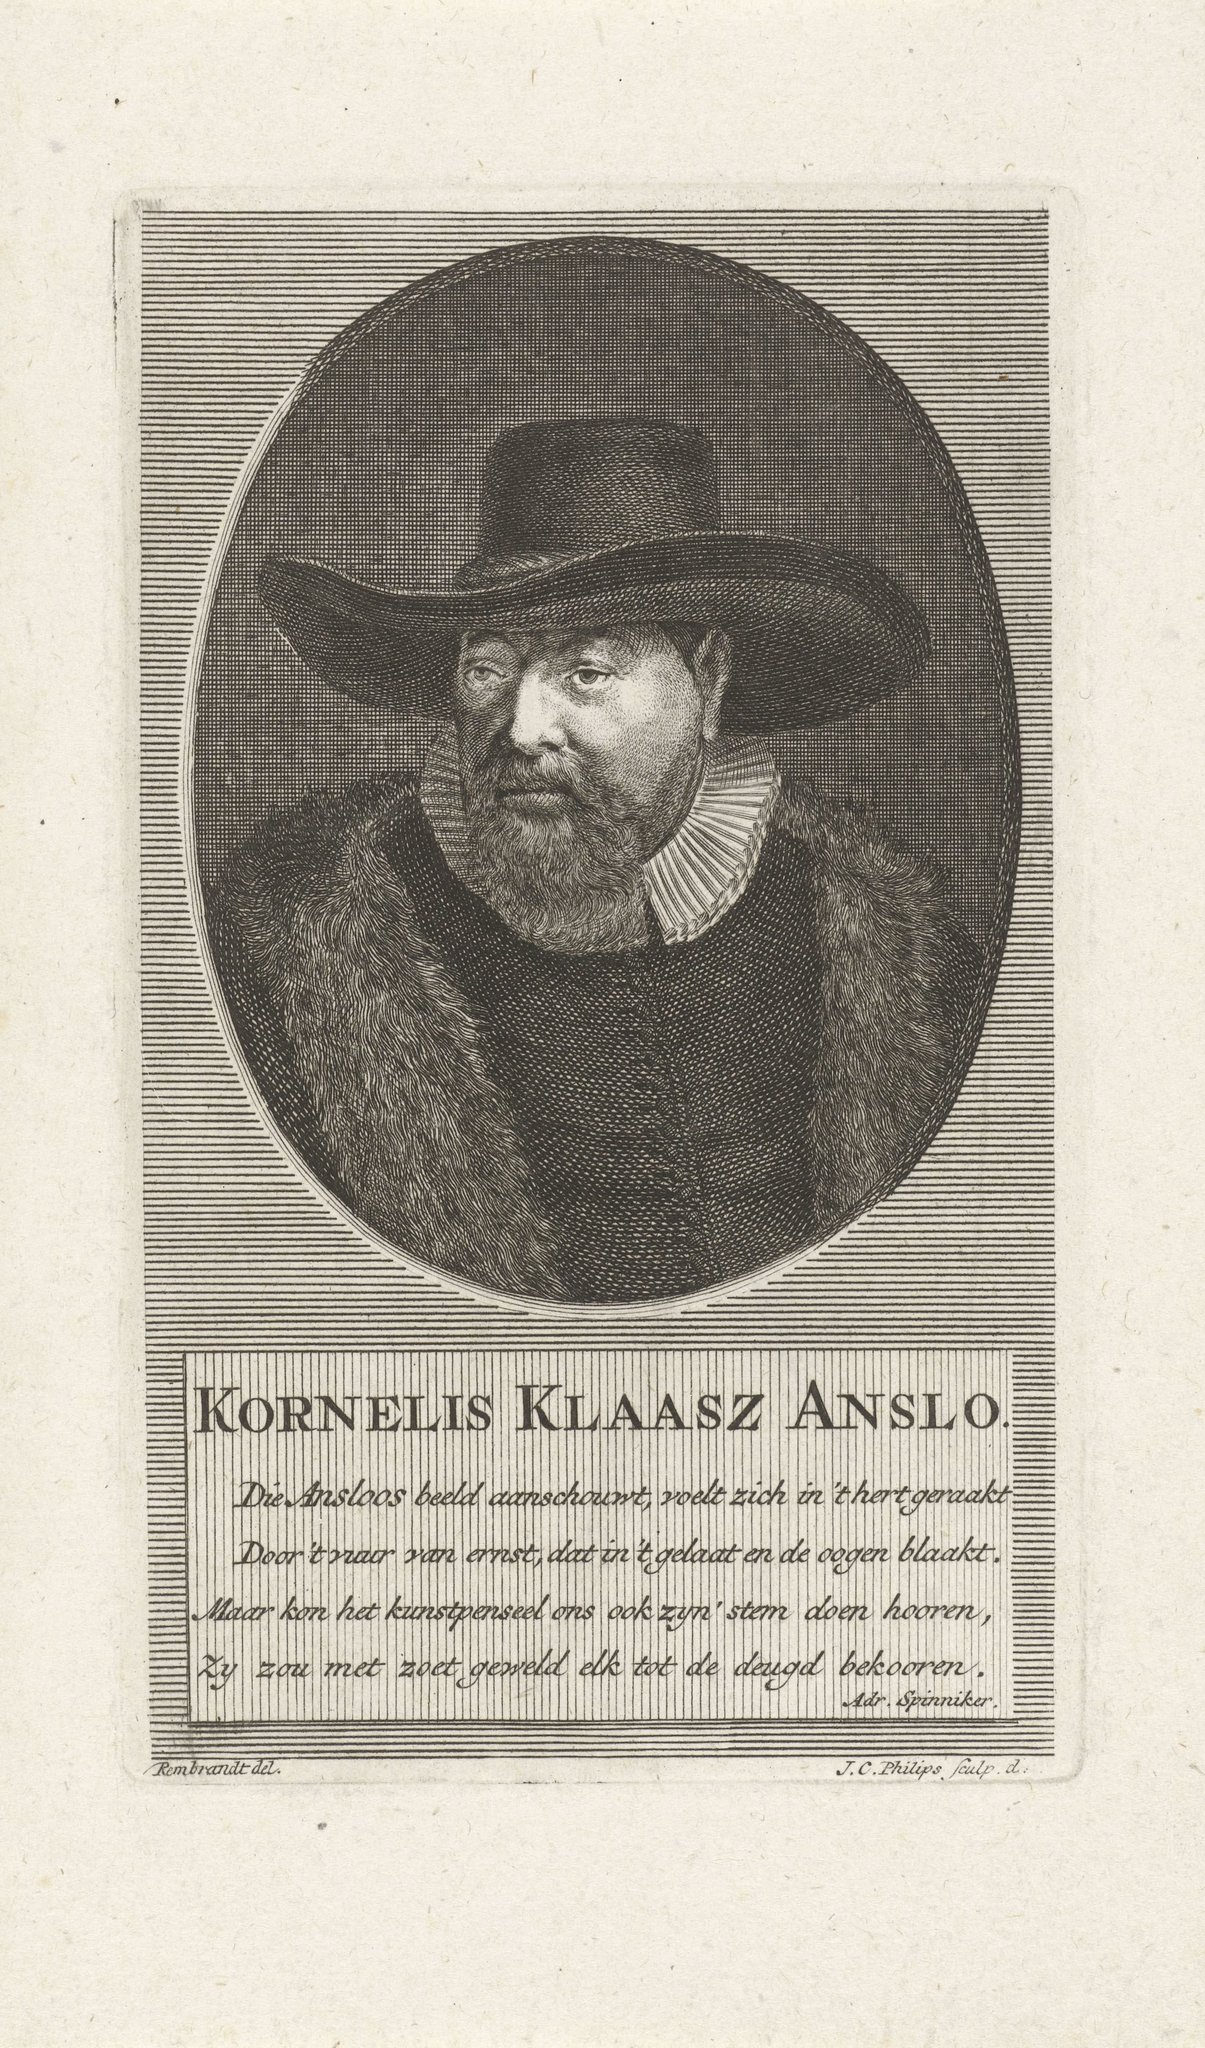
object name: print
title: Portret van de doopsgezinde predikant Cornelis Claesz. Anslo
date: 1736-1743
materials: paper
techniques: engraving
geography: amsterdam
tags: predikant, koopman, cornelis claesz. anslo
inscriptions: collector's mark: Lugt 2228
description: Portret van de doopsgezinde predikant Cornelis Claesz. Anslo. In het kader een vierregelig lofdicht in het Nederlands.